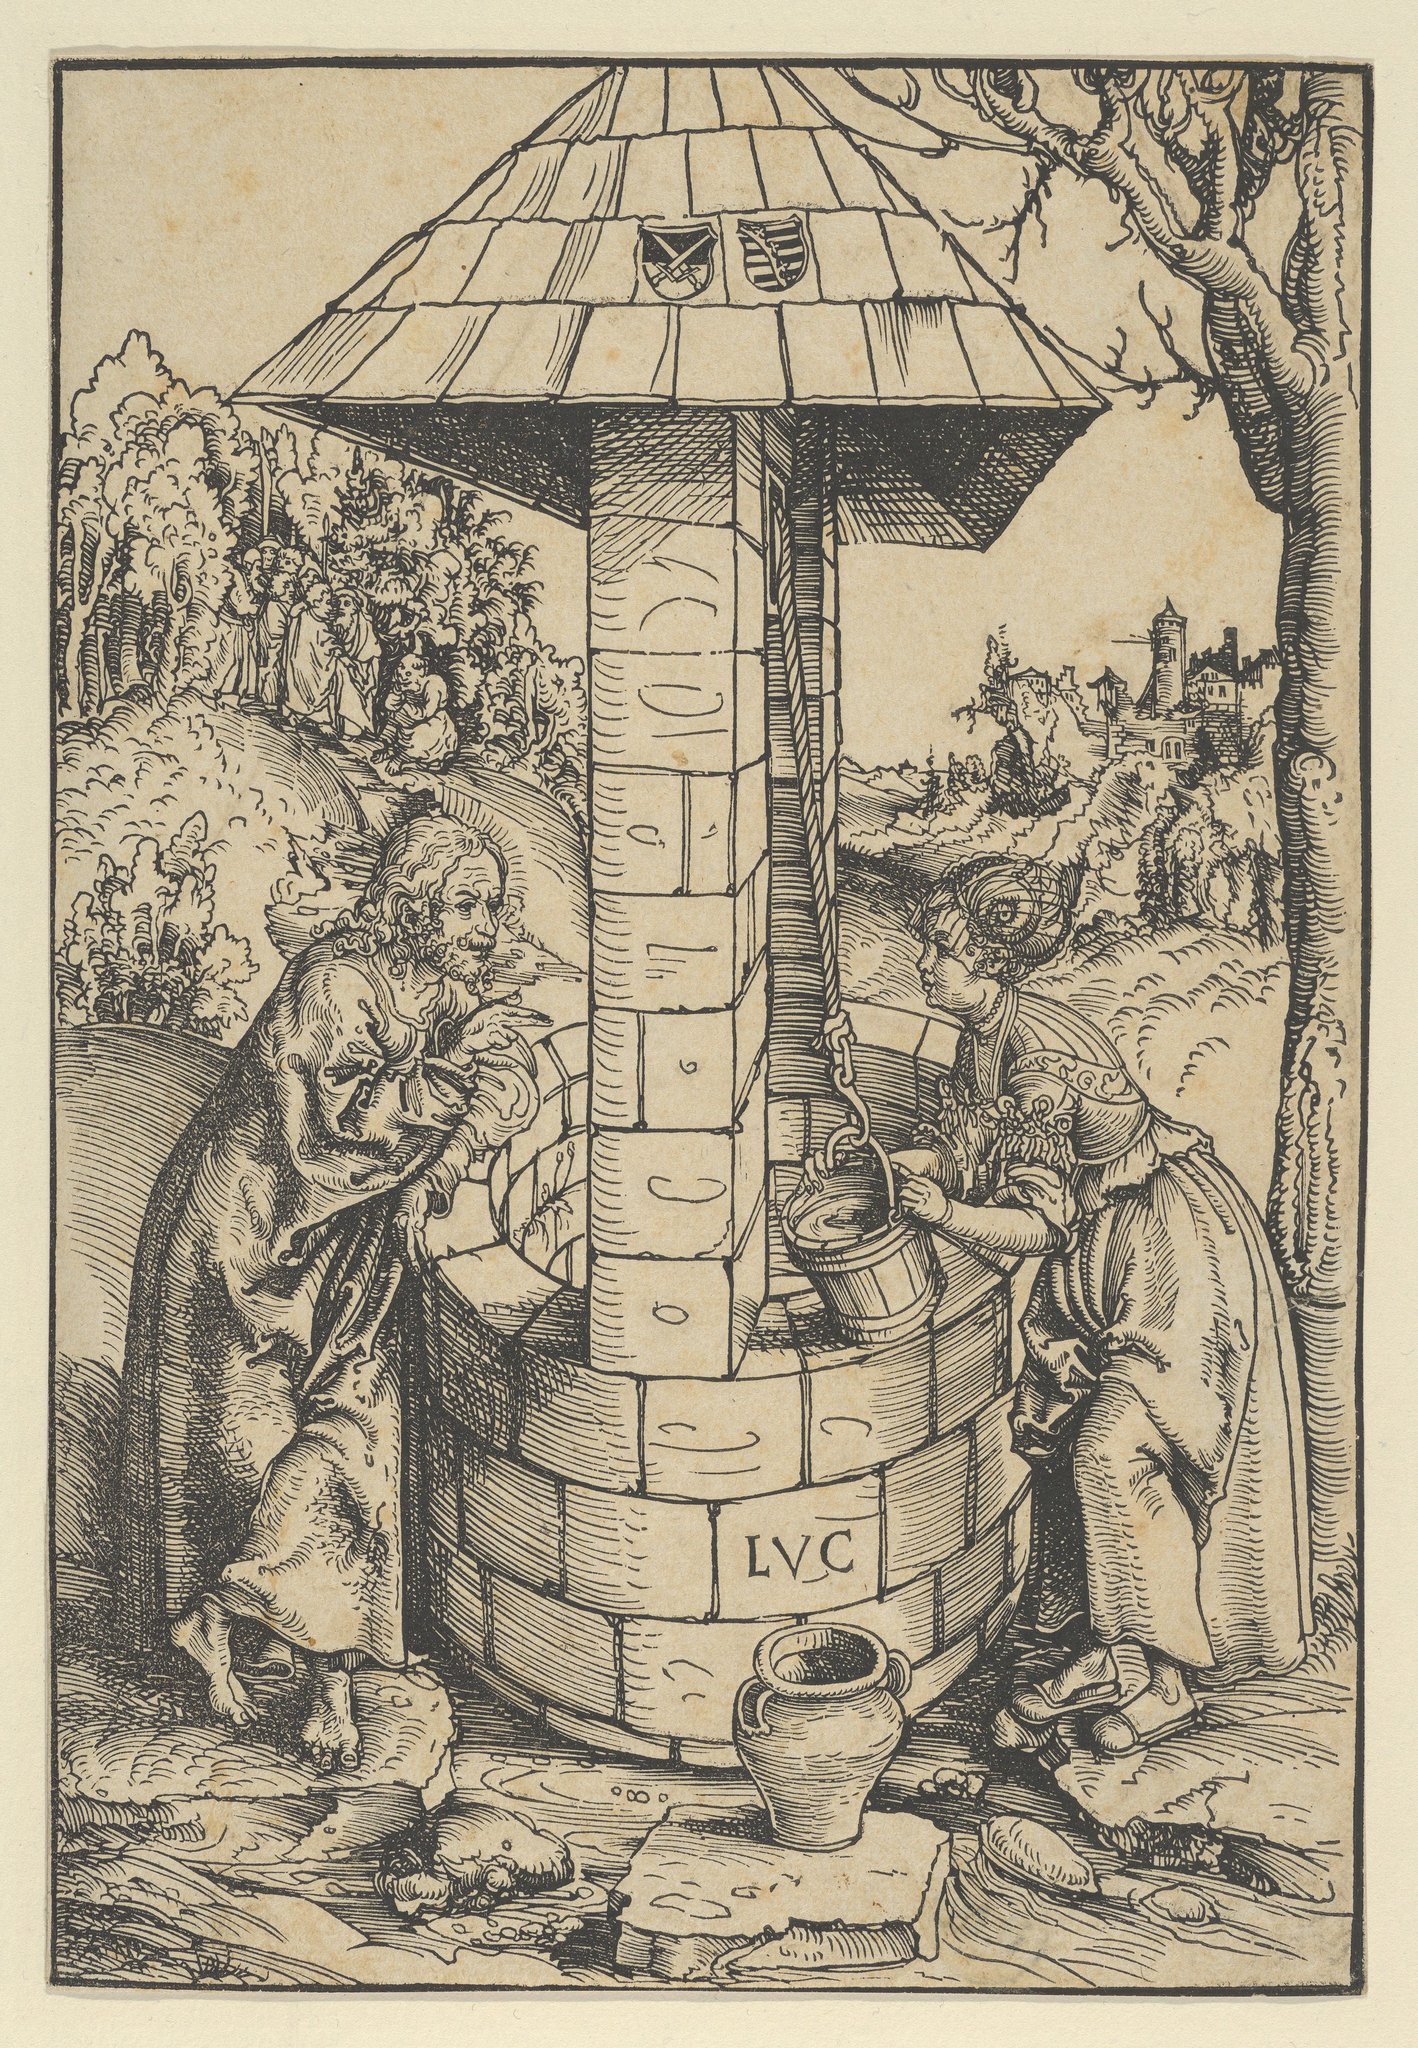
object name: print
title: Christ and the Woman of Samaria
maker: lucas cranach the elder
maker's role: artist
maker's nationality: german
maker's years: 1472-1553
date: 1472-1553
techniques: woodcut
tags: wells,women,christ